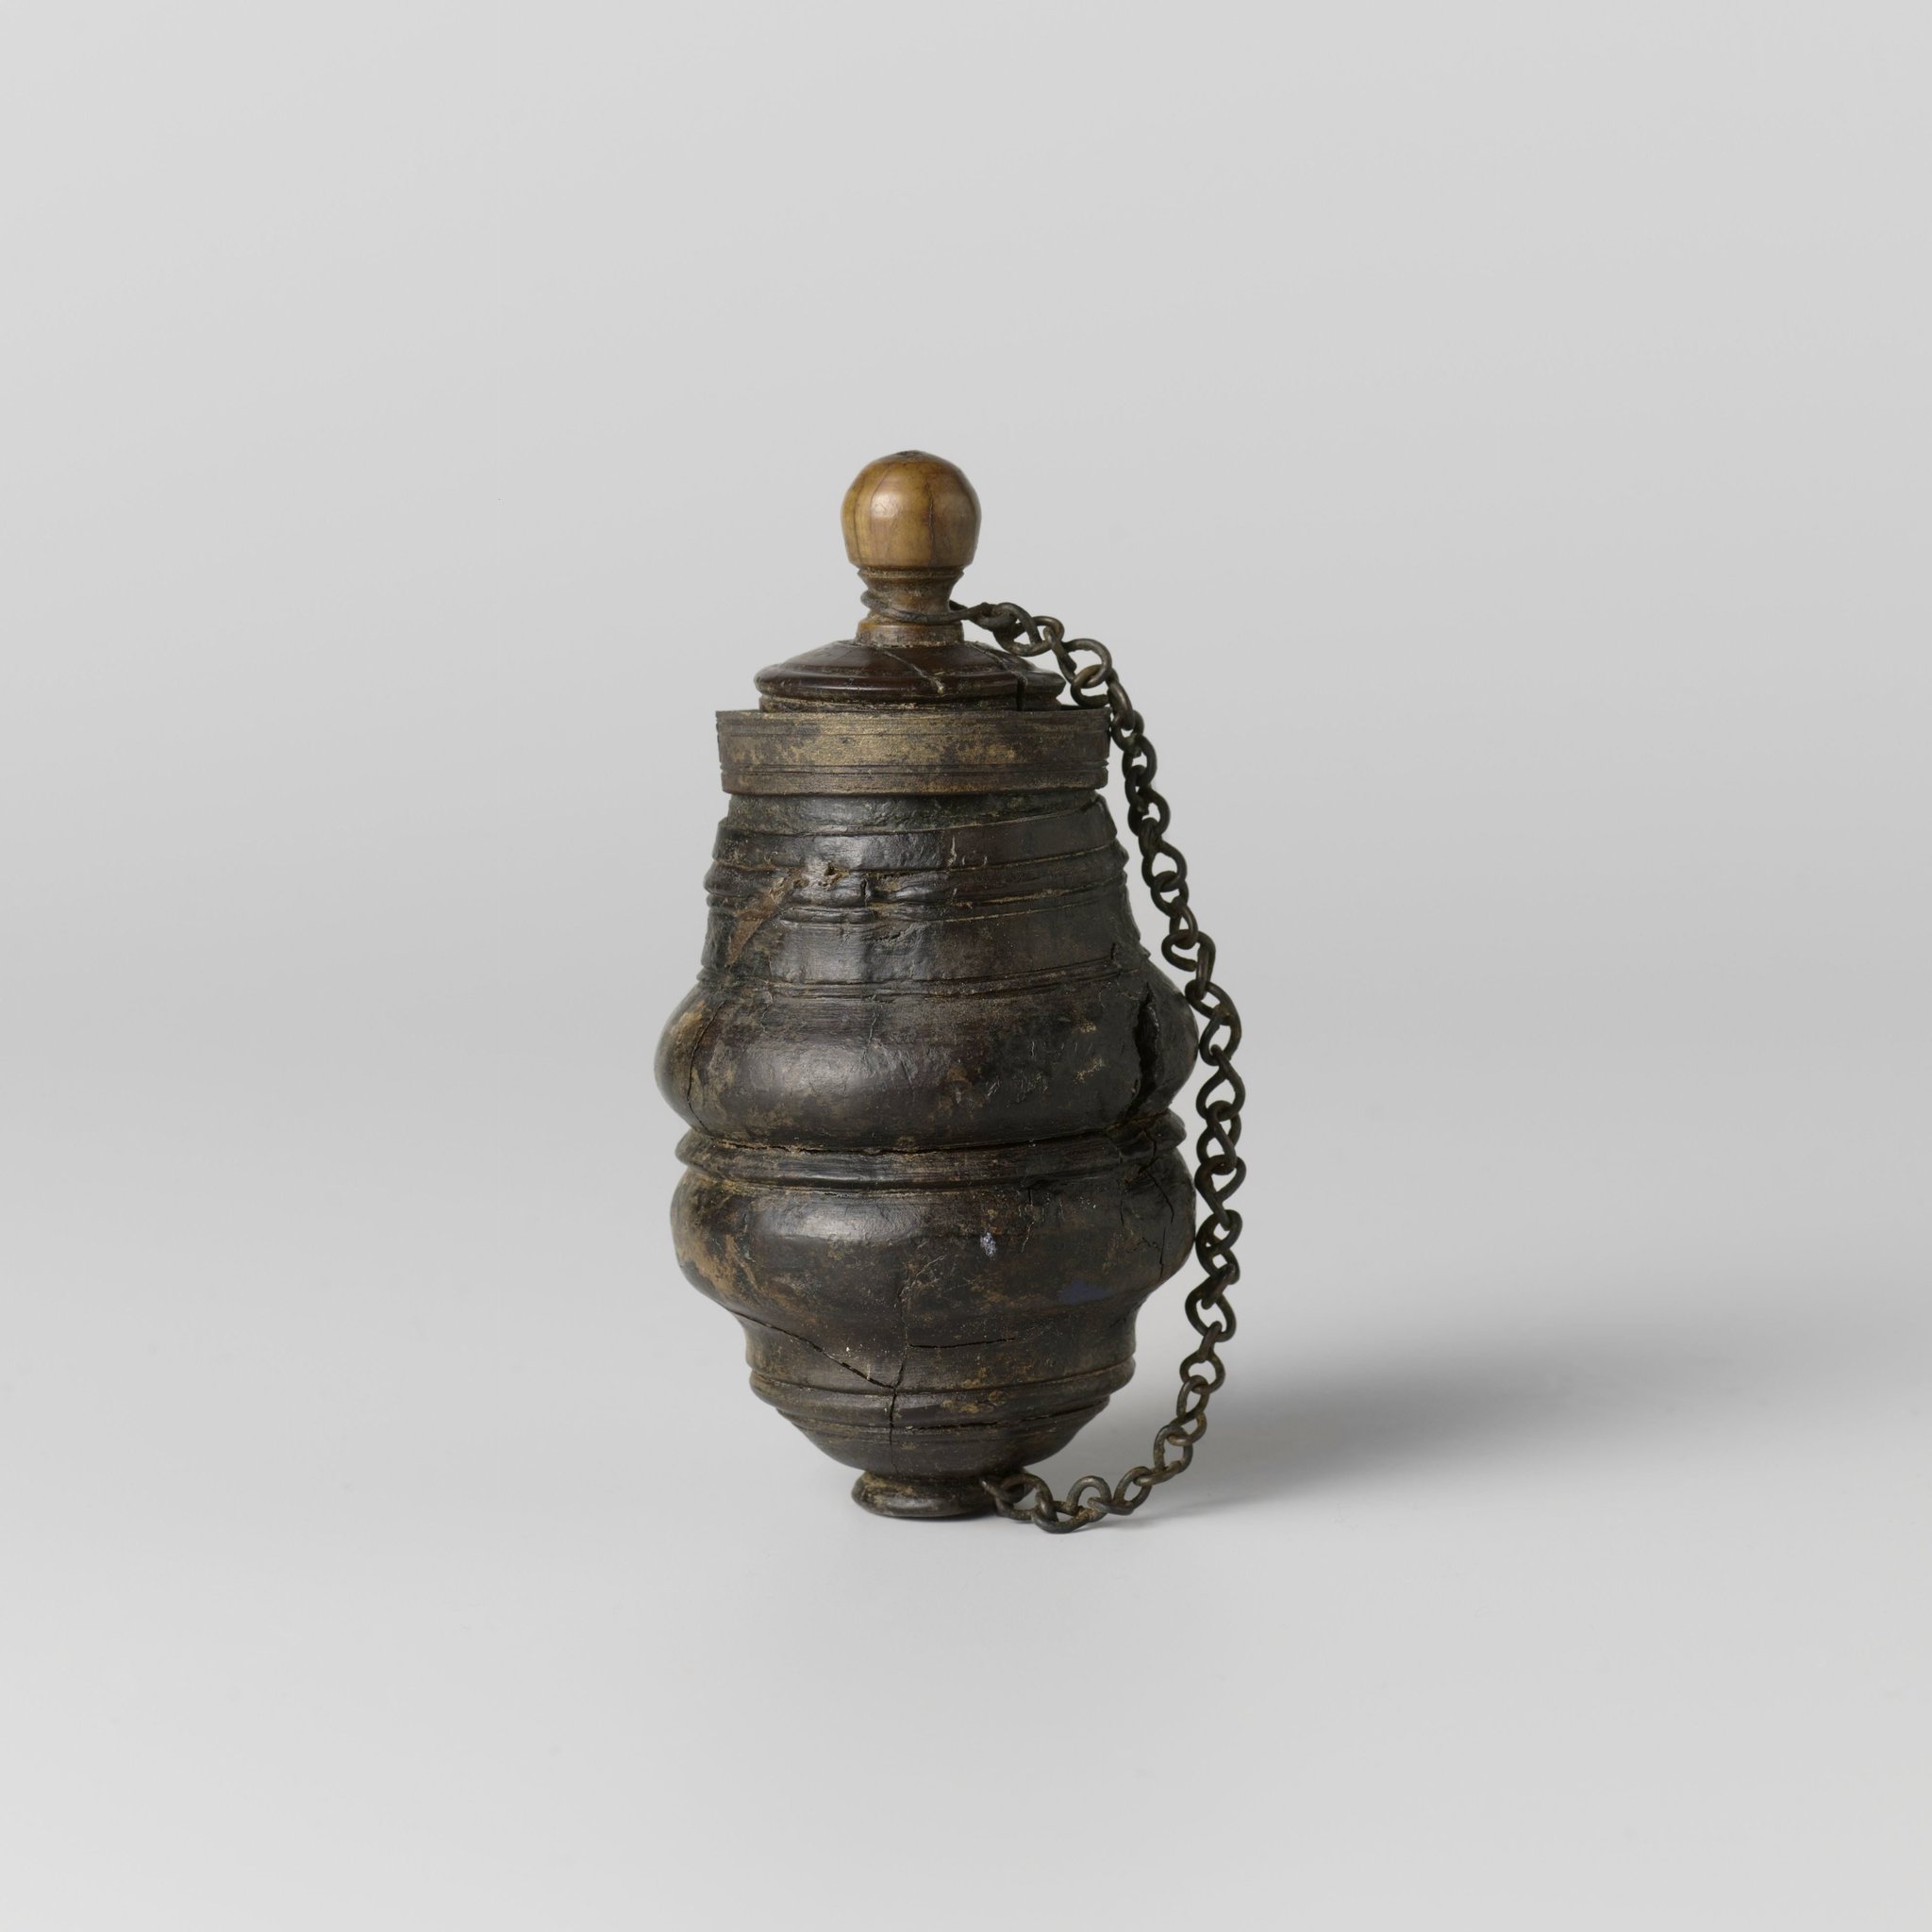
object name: pot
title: Wouden tinderbox from the wreck of the Dutch East Indiaman Hollandia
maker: Anonymous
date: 1700-1743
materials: bone, copper, wood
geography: netherlands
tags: verenigde oostindische compagnie, hollandia (schip), annet